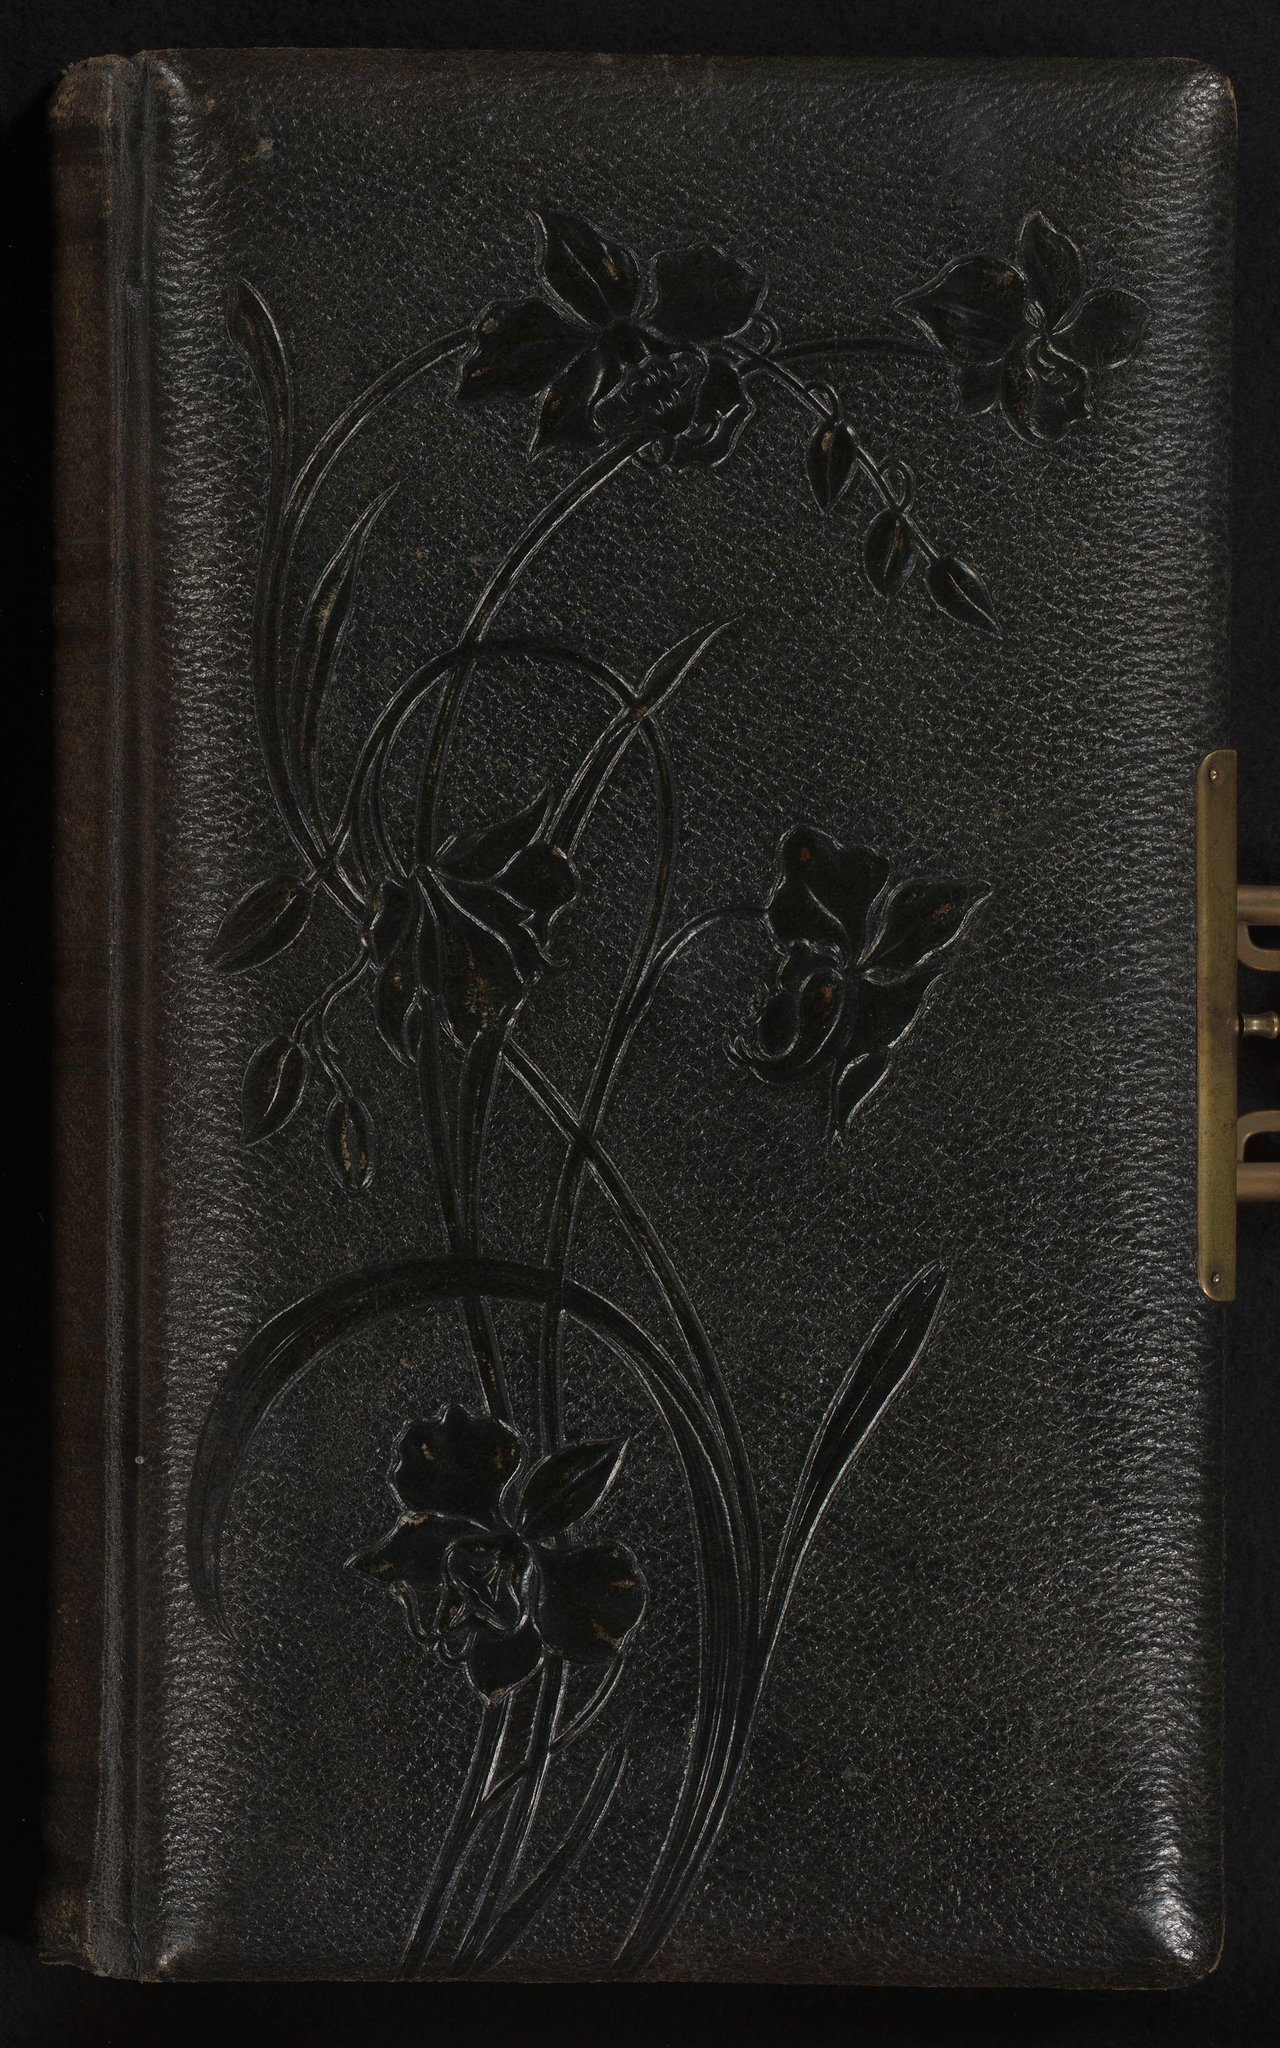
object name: slip in album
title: Fotoalbum (leeg)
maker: Anonymous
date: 1860-1920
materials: cardboard, leather, metal, paper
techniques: decorated paper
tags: flowers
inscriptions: collector's mark: ‘DIENST/ VERSPREIDE/ RIJKSKOLLEKTIES/ (...) A 973’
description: Fotoalbum met 28 pagina's met ofwel een met gouden lijnen omkaderde passe-partout voor een kabinetfoto, ofwel boven elkaar 2 met gouden lijnen omkaderde passe-partouts voor cartes-de-visite. In totaal is er in het album plaats voor 8 kabinetfoto's en 40 cartes-de-visite.